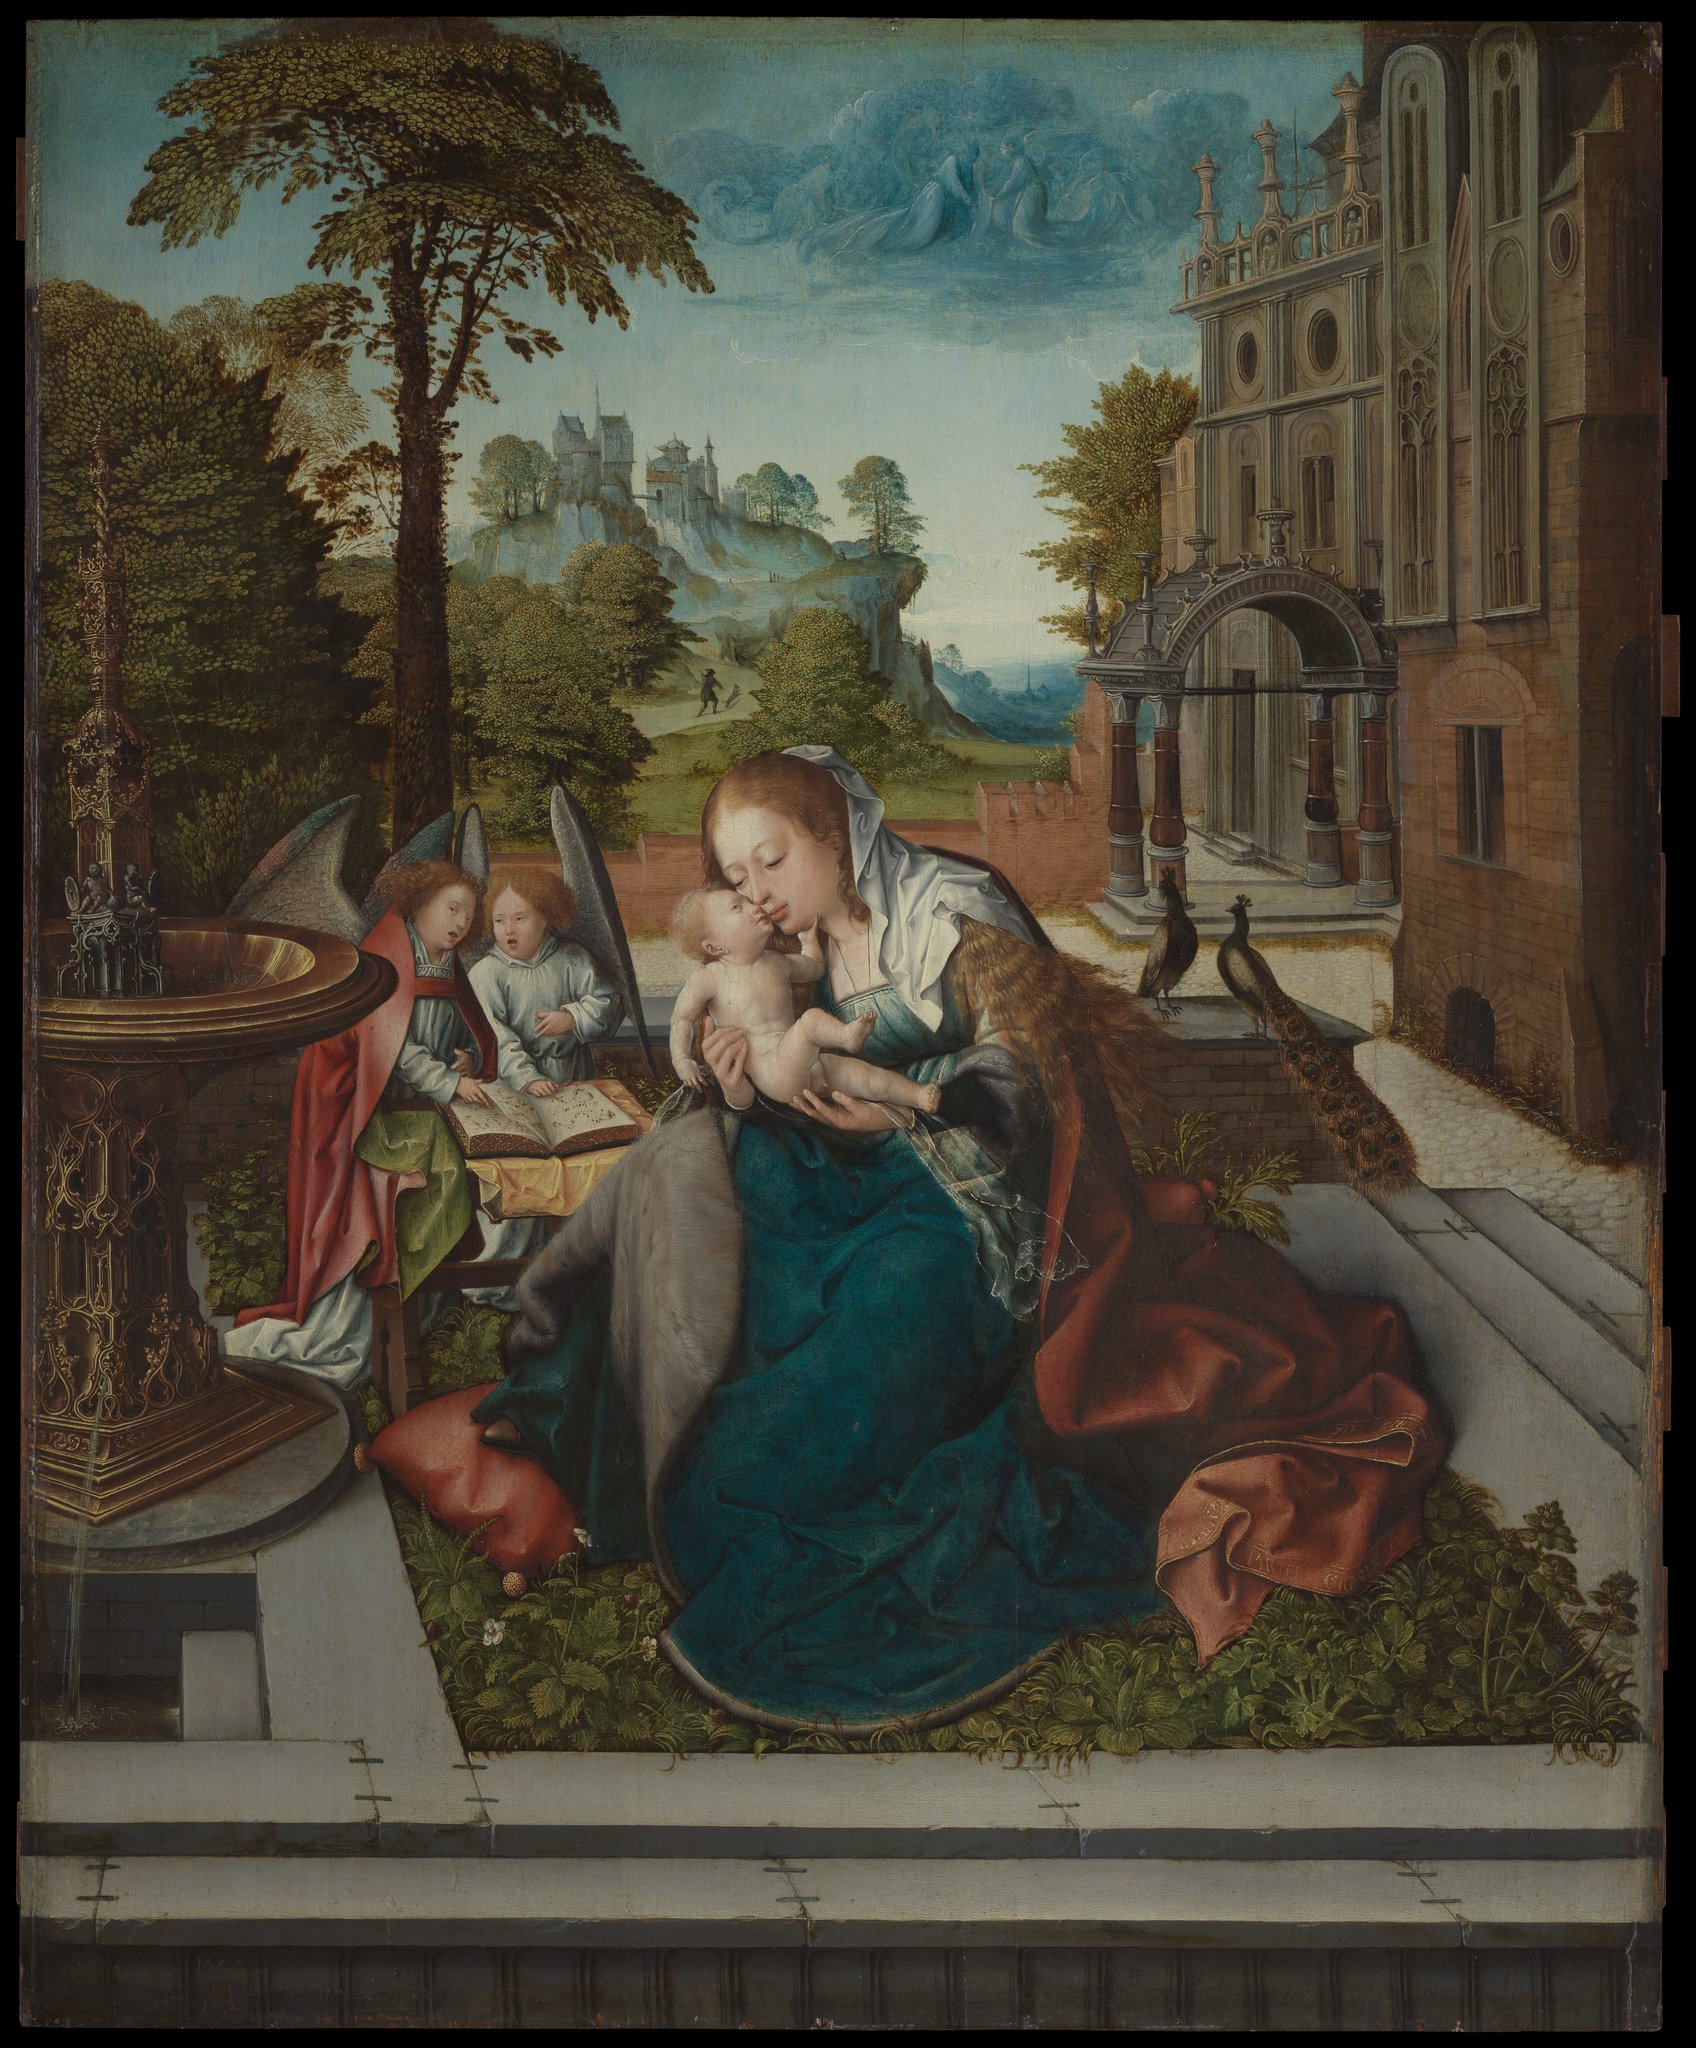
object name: painting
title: Virgin and Child with Angels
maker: bernard van orley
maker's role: artist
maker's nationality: netherlandish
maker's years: 1492-1542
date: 1518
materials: oil, wood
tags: fountains,music,peacocks,angels,madonna and child